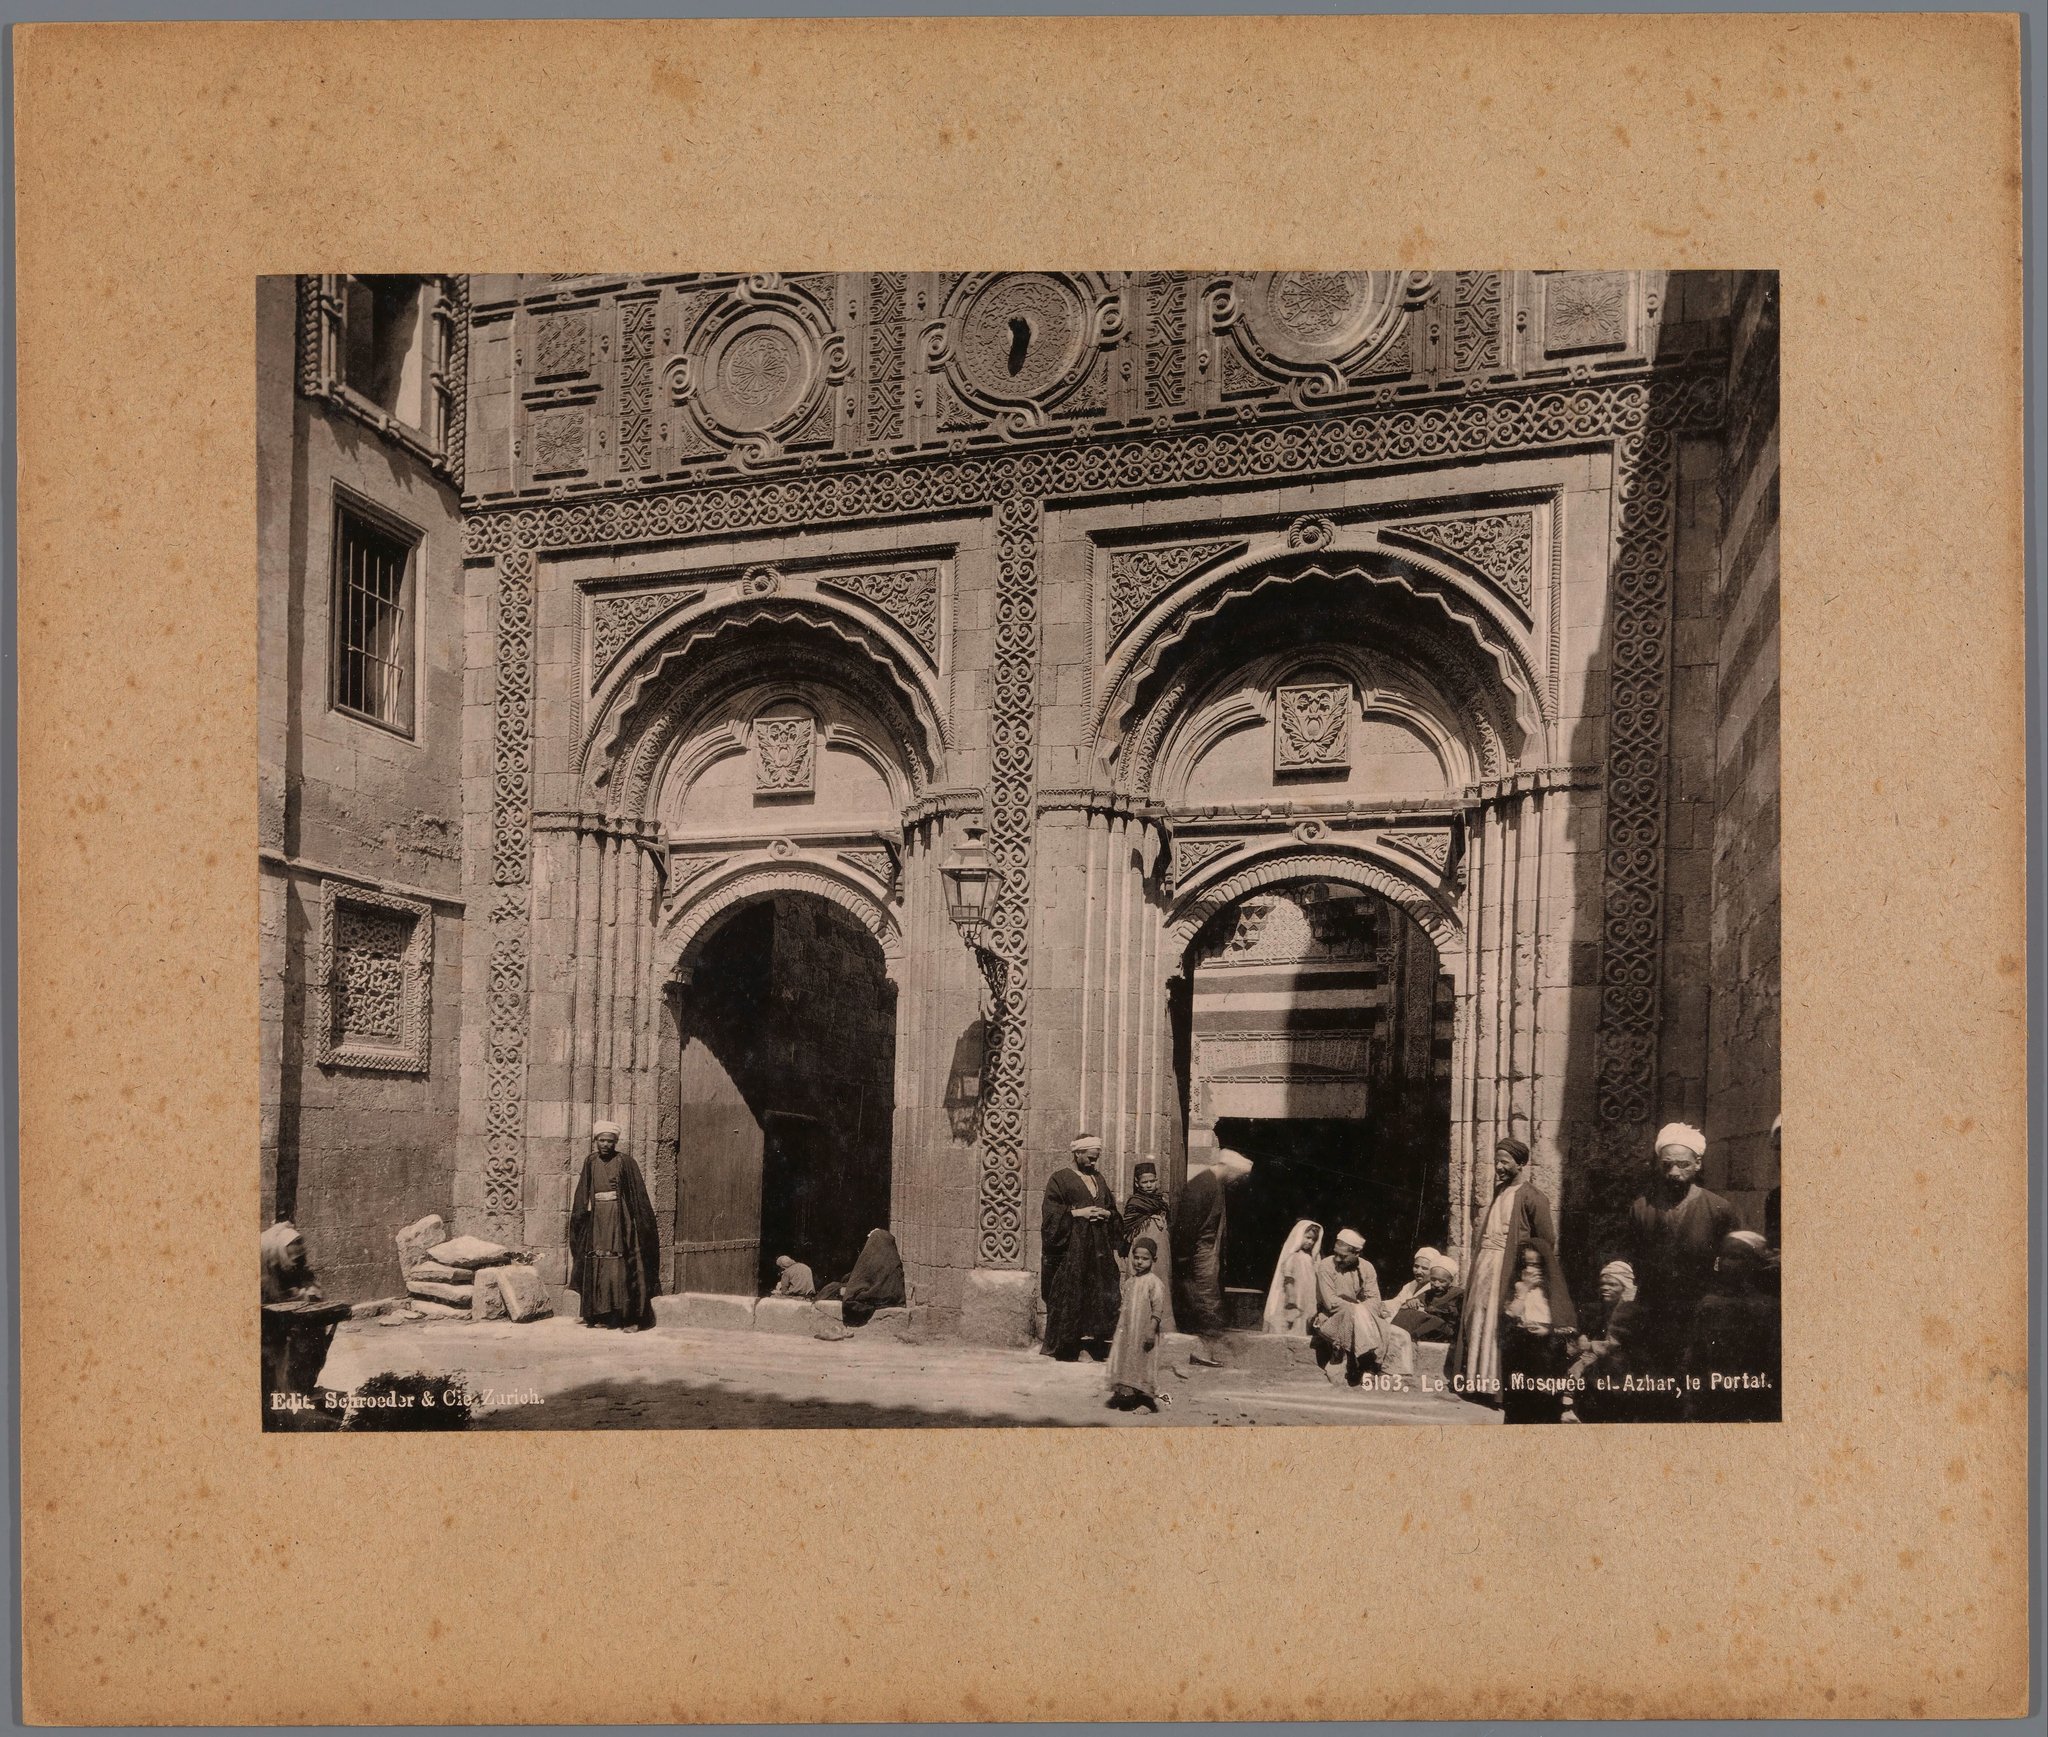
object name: photograph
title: Portaal van de Al-Azhar-moskee te Caïro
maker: Anonymous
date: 1875-1900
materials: cardboard, paper, ink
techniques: photograph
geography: cairo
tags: parts of church exterior and annexes: porch, flat decoration ~ applied arts (+ islamic art), temple, shrine ~ islam, mohammedanism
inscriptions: number: ‘5163.’, collector's mark: ‘INSTITUUT VOOR KUNST-NIJVERHEIDSONDERWIJS GABRIËL METSUSTRAAT No. 16 AMSTERDAM’, collector's mark: ‘KUNSTNIJVERHEIDSCHOOL QUELLINUS AMSTERDAM FRANS HALSSTRAAT 14.’